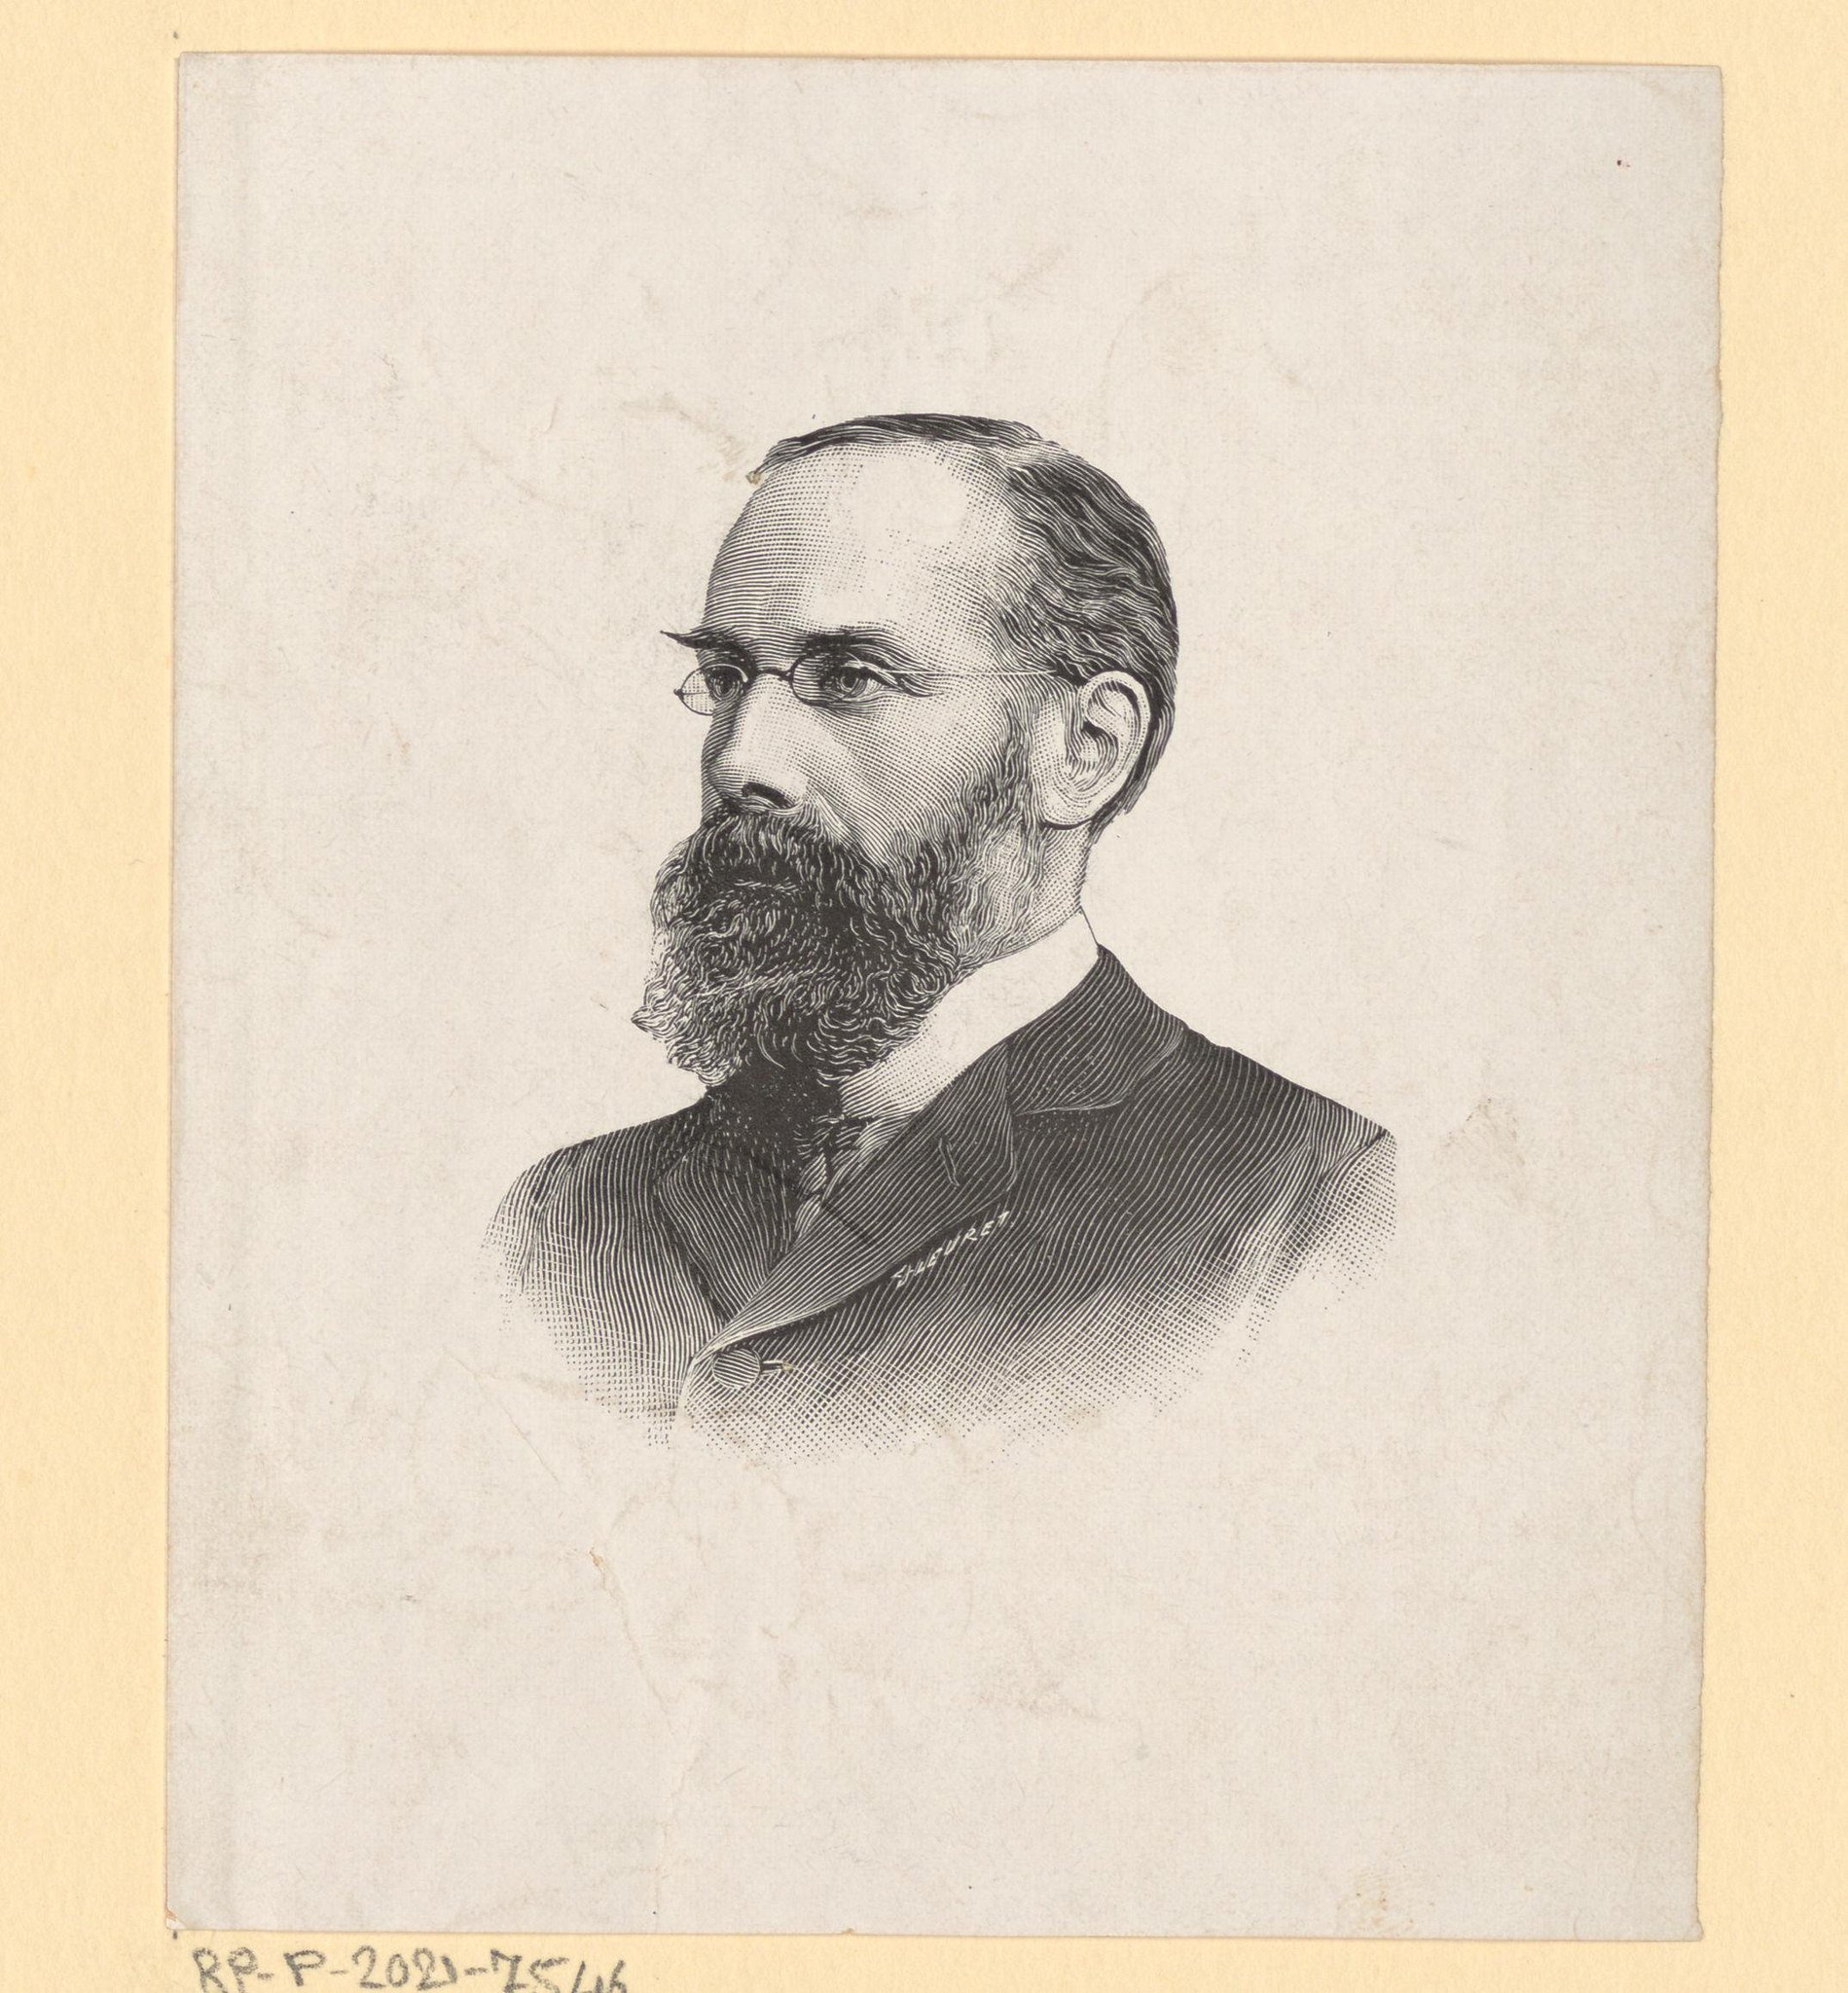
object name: print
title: Portret van Barthold Willem Floris van Riemsdijk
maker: bertrant fleuret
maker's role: print maker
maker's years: 1820-1910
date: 1870-1910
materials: paper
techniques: engraving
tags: maastricht, amsterdam, print maker, engineer, jonkheer barthold willem floris van riemsdijk, historical persons